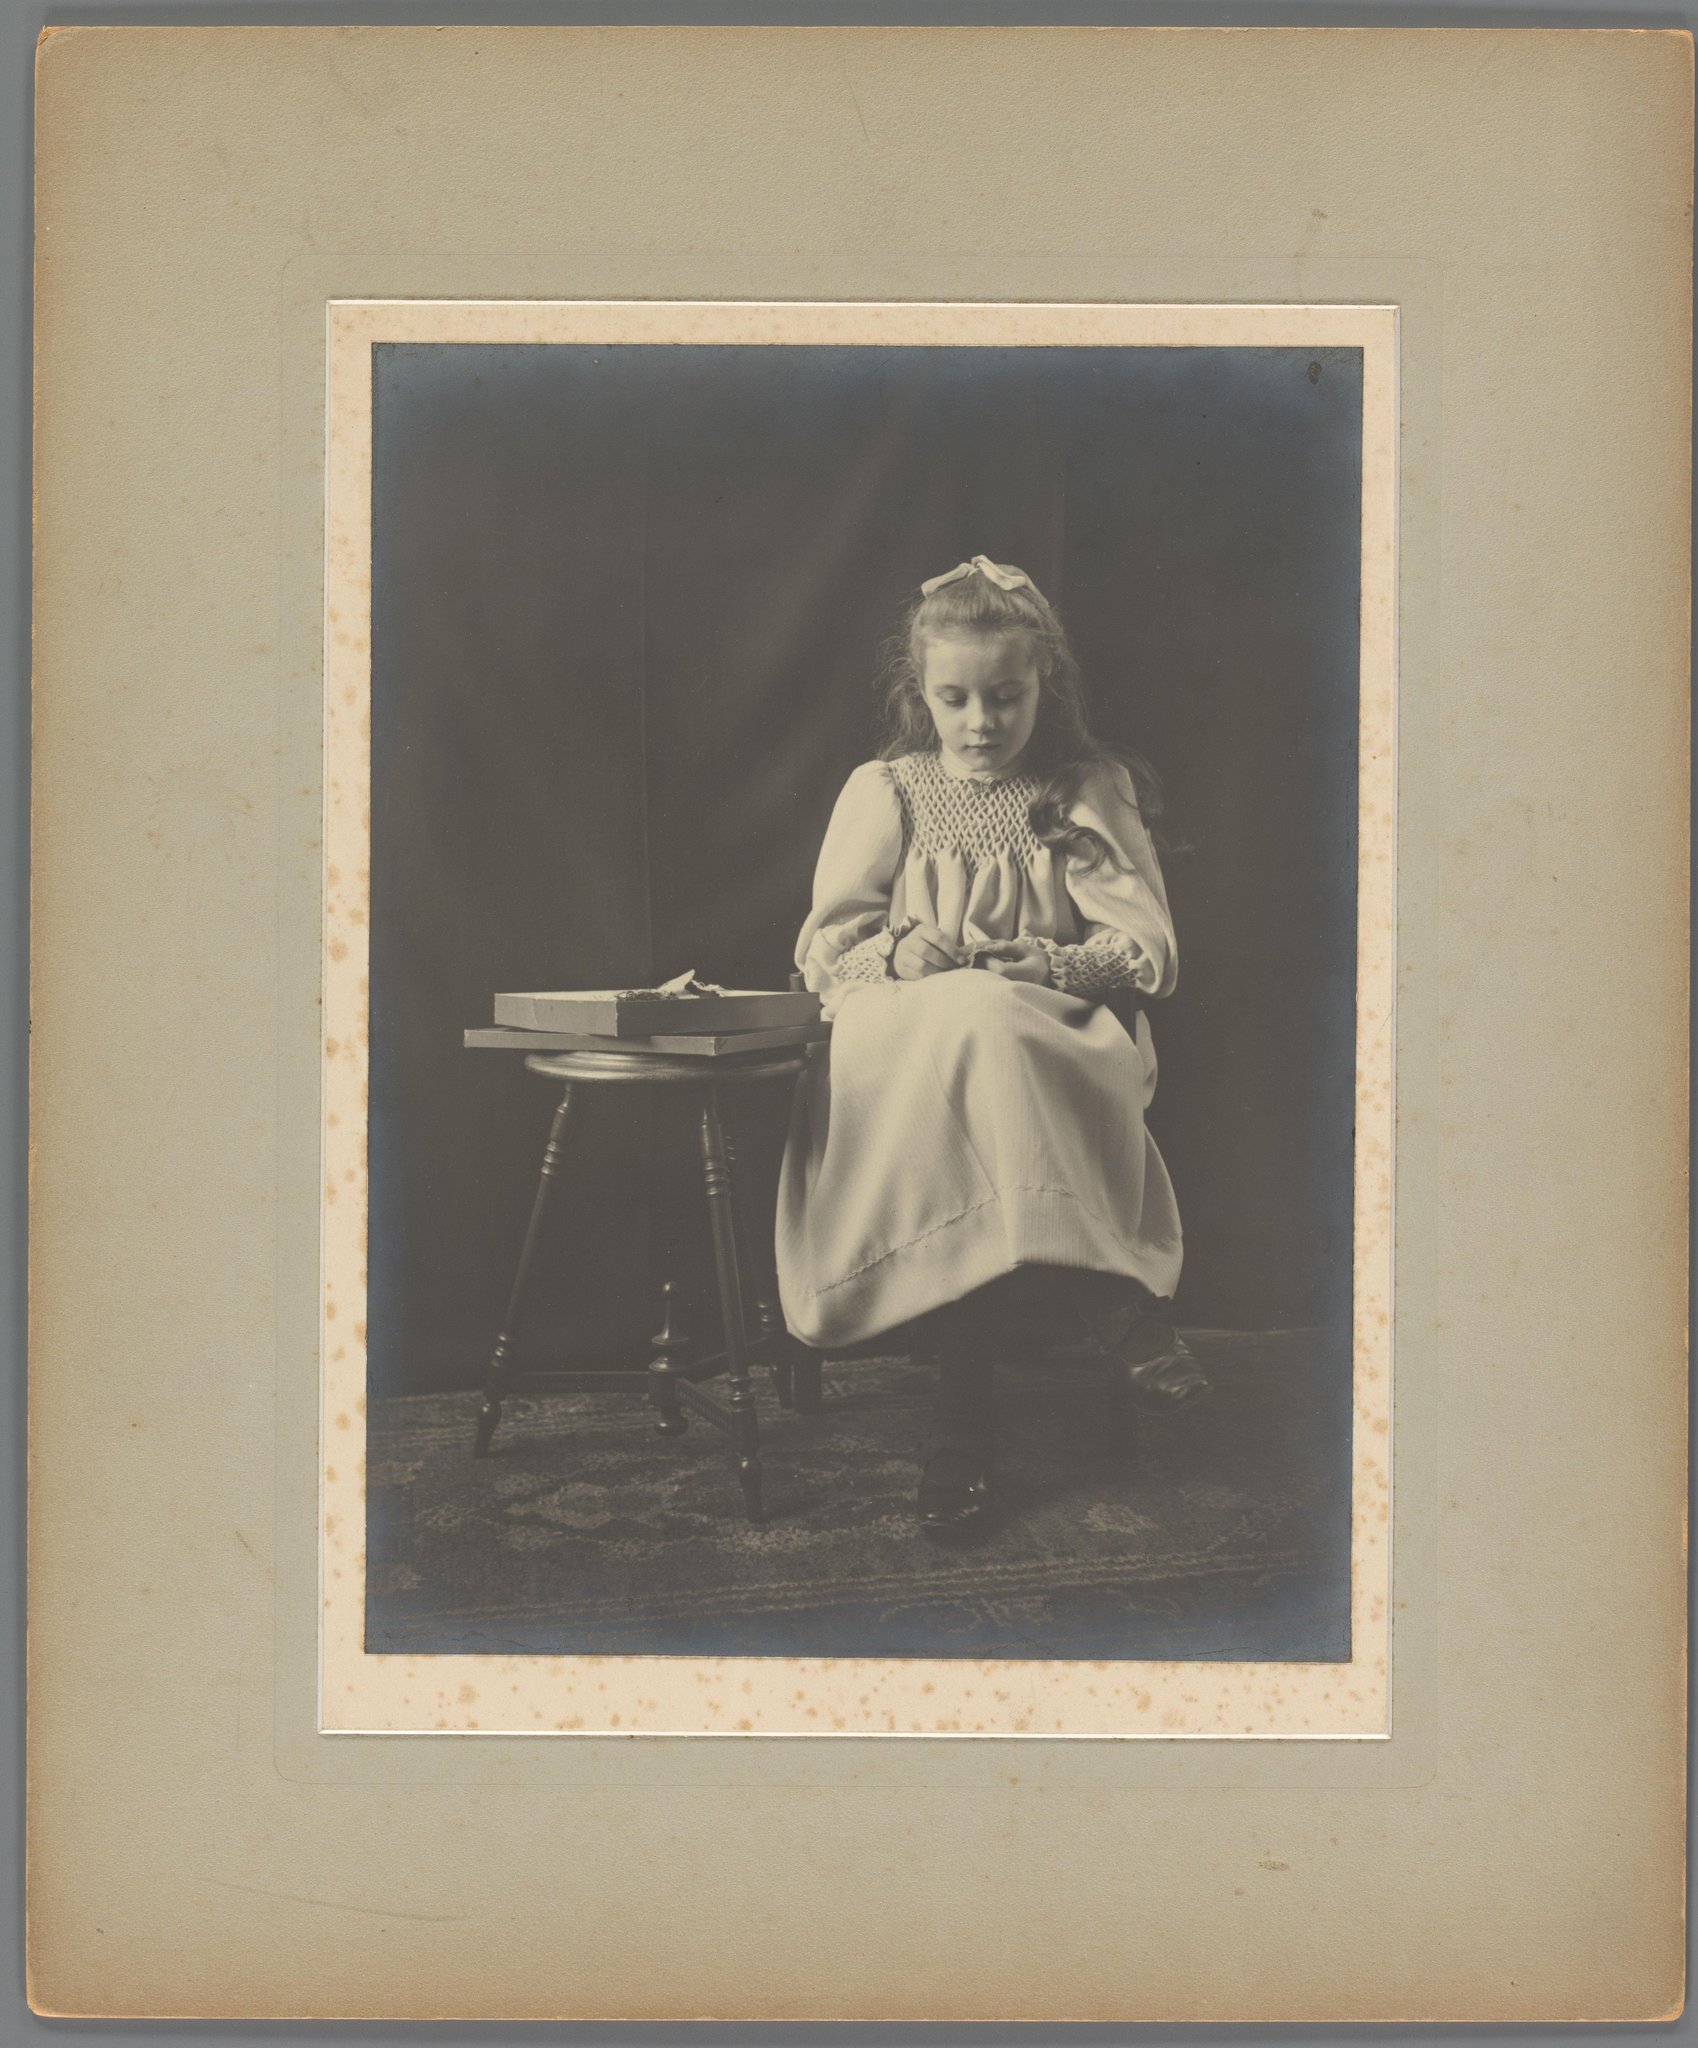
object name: photograph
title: Portret van Johanna (Hans) de Jong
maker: willem de jong (fotograaf)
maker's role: arts, fotograaf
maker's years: 1864-1918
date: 1905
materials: paper, cardboard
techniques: gelatin silver print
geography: netherlands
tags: leiden, johanna petronella lambertina stokhuyzen-de jong (hans), historical persons, girl (child between toddler and youth)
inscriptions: inscription: ‘H’